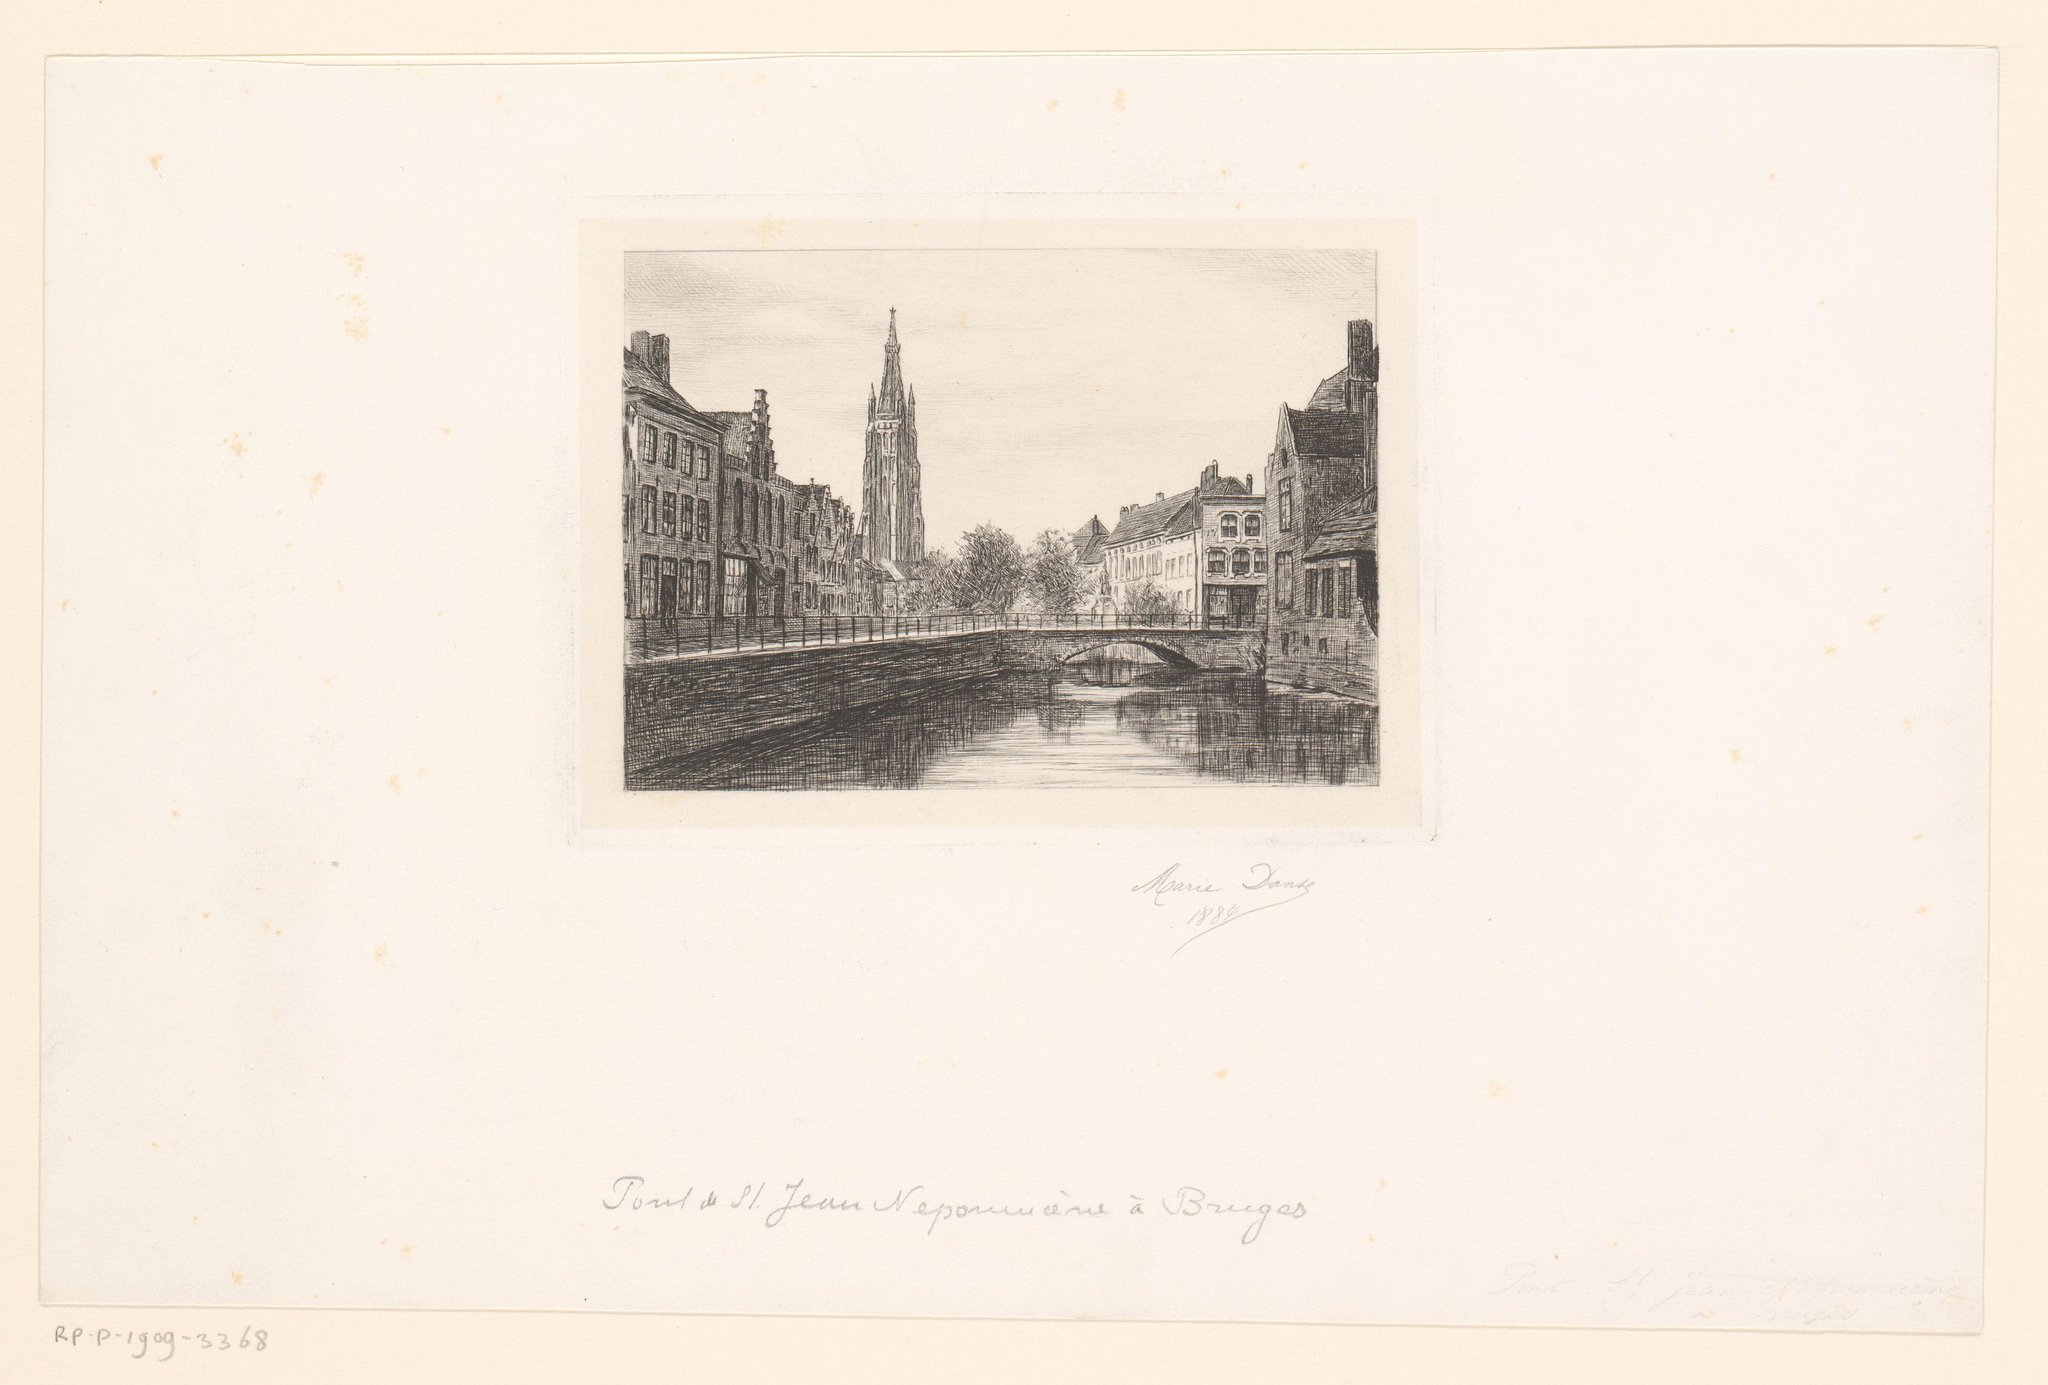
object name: print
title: Brug van Sint-Jean Nepomucène te Brugge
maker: marie danse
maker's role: print maker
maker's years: 1867-1942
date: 1884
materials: paper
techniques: etching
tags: bridge in city across river, canal, etc., bruges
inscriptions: inscription: ‘Pont de St. Jean Nepomucène à Bruges’, collector's mark: Lugt 2228